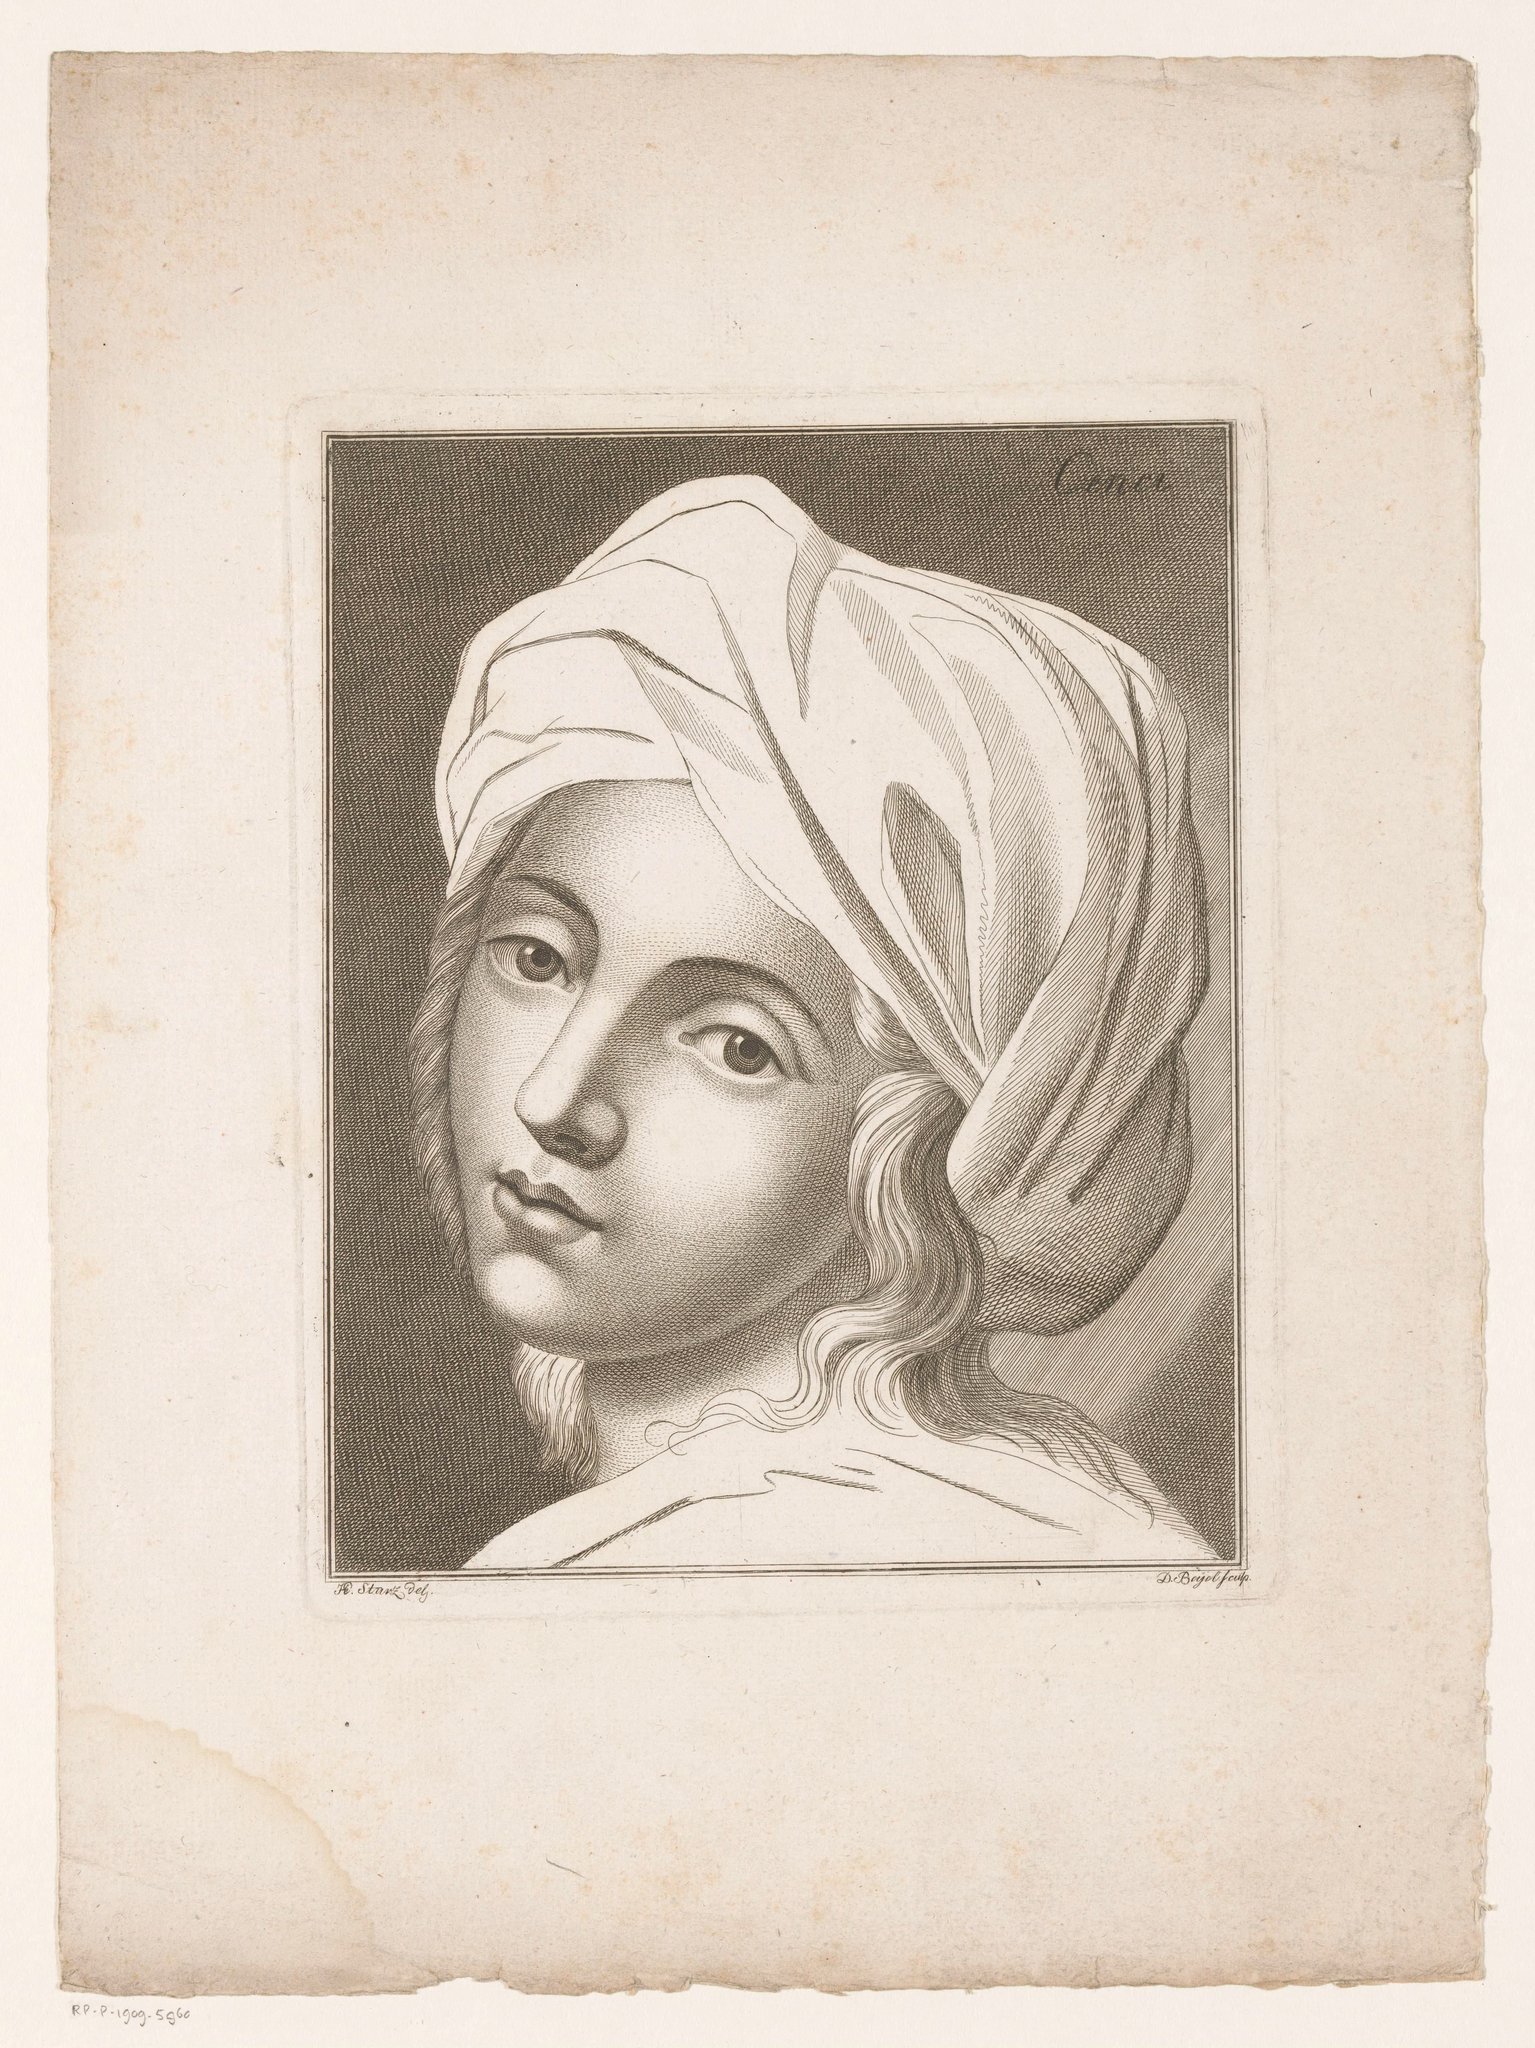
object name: print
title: Cenci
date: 1785-1823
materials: paper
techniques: engraving, etching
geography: munich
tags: historical persons - bb - woman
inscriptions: collector's mark: Lugt 2228